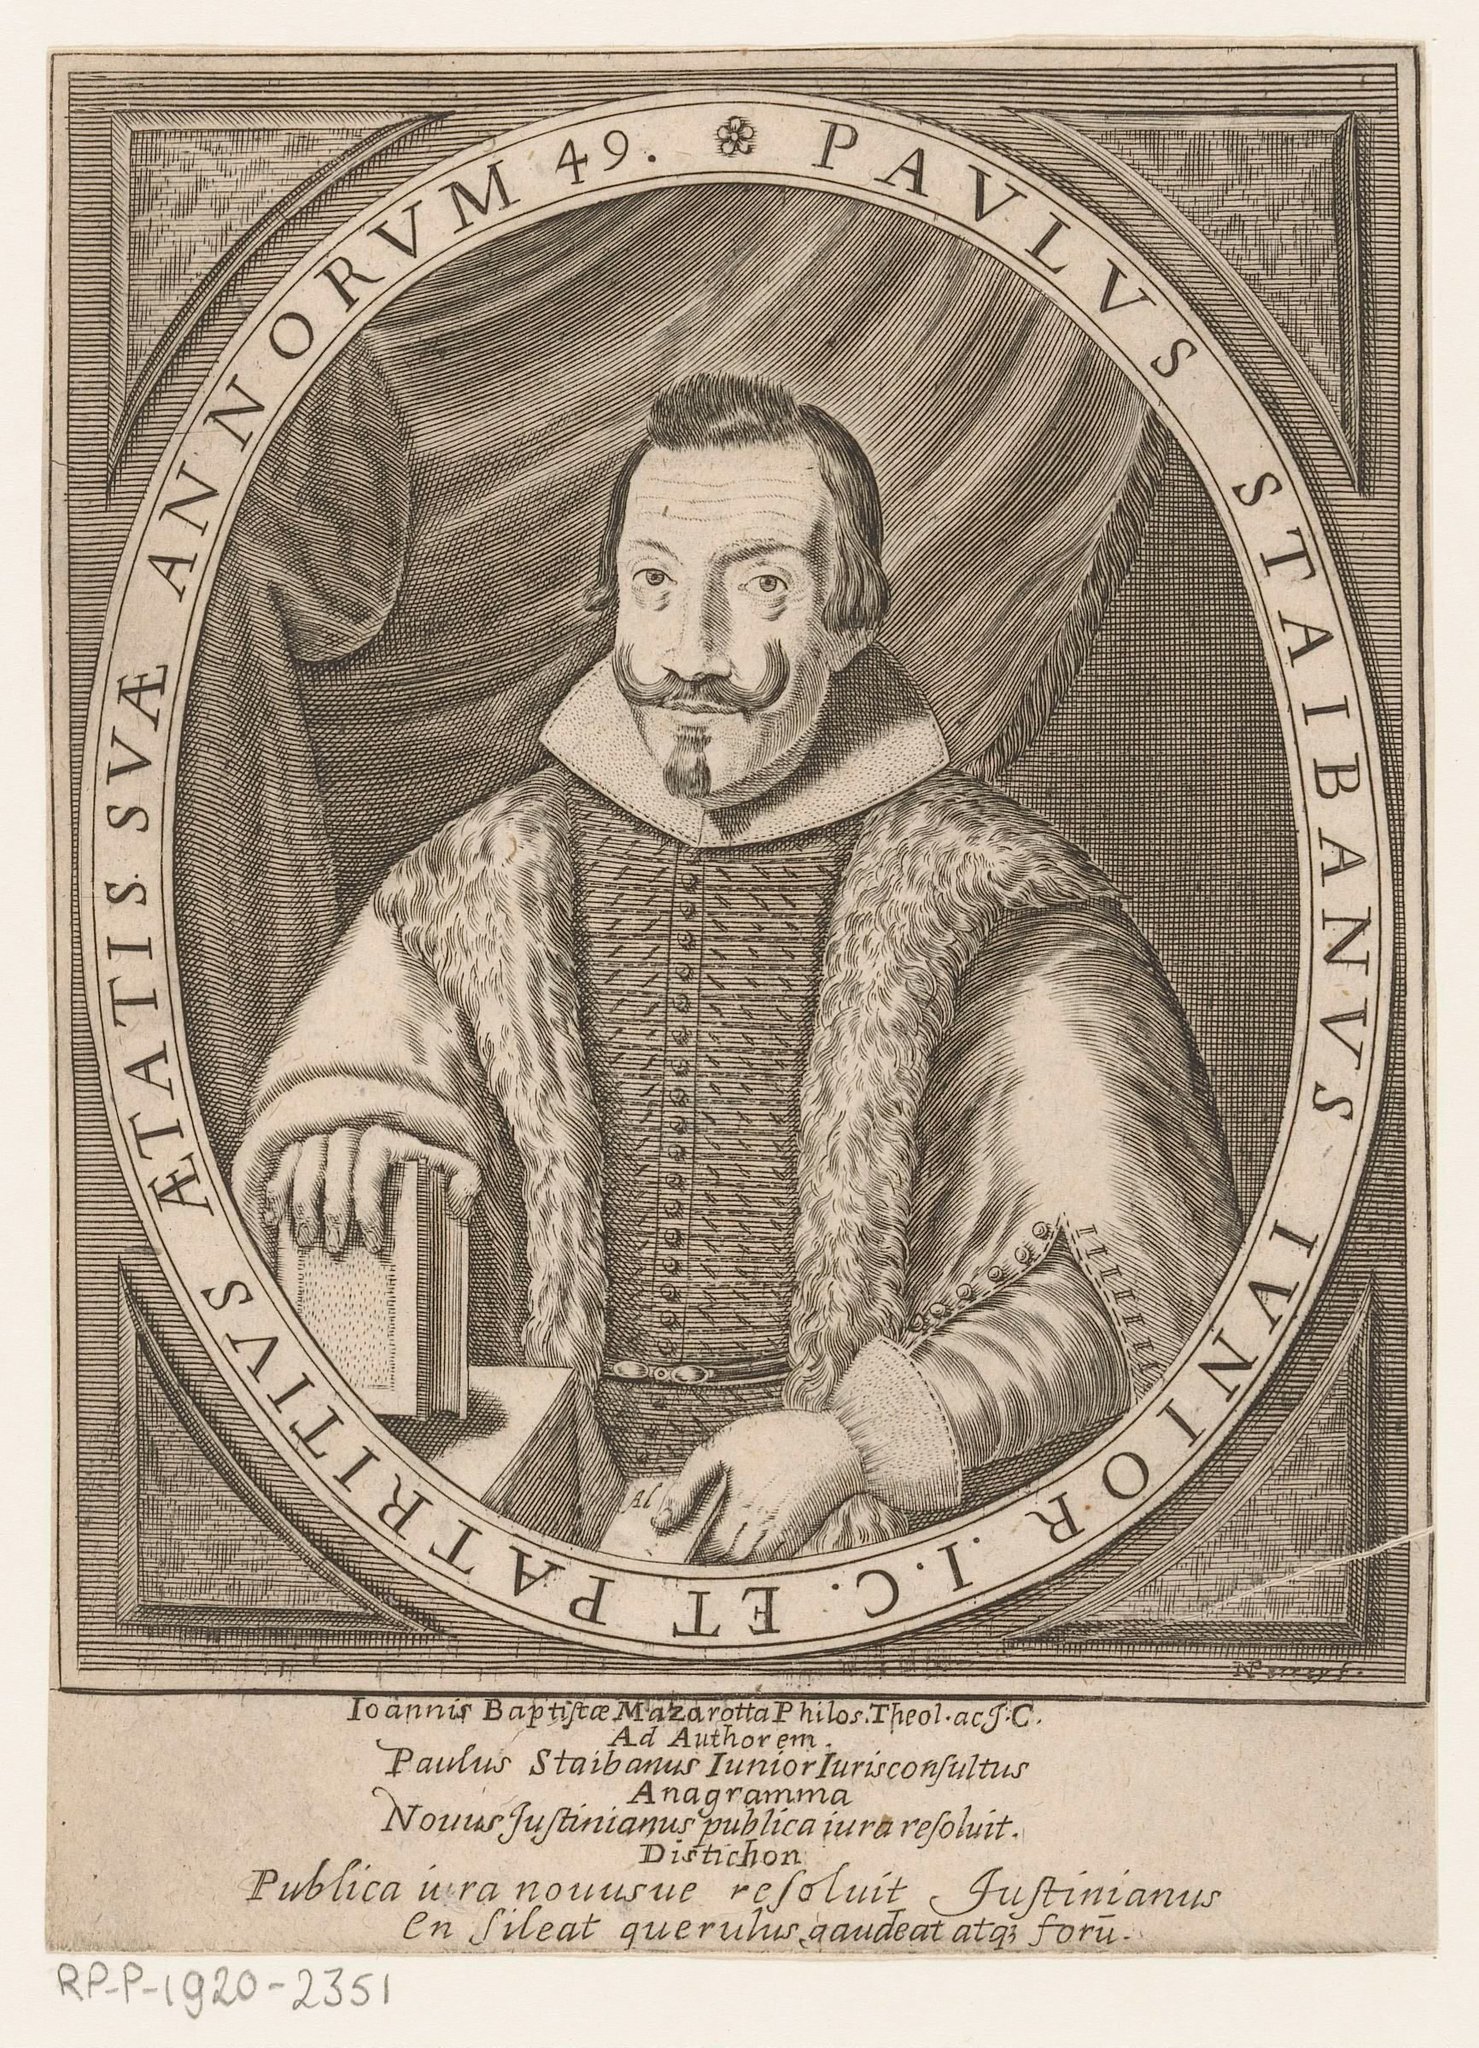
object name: print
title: Portret van jurist Paolo Staibano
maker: nicolas perrey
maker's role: print maker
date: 1600-1699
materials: paper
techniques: engraving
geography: italy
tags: historical persons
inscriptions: collector's mark: Lugt 2228